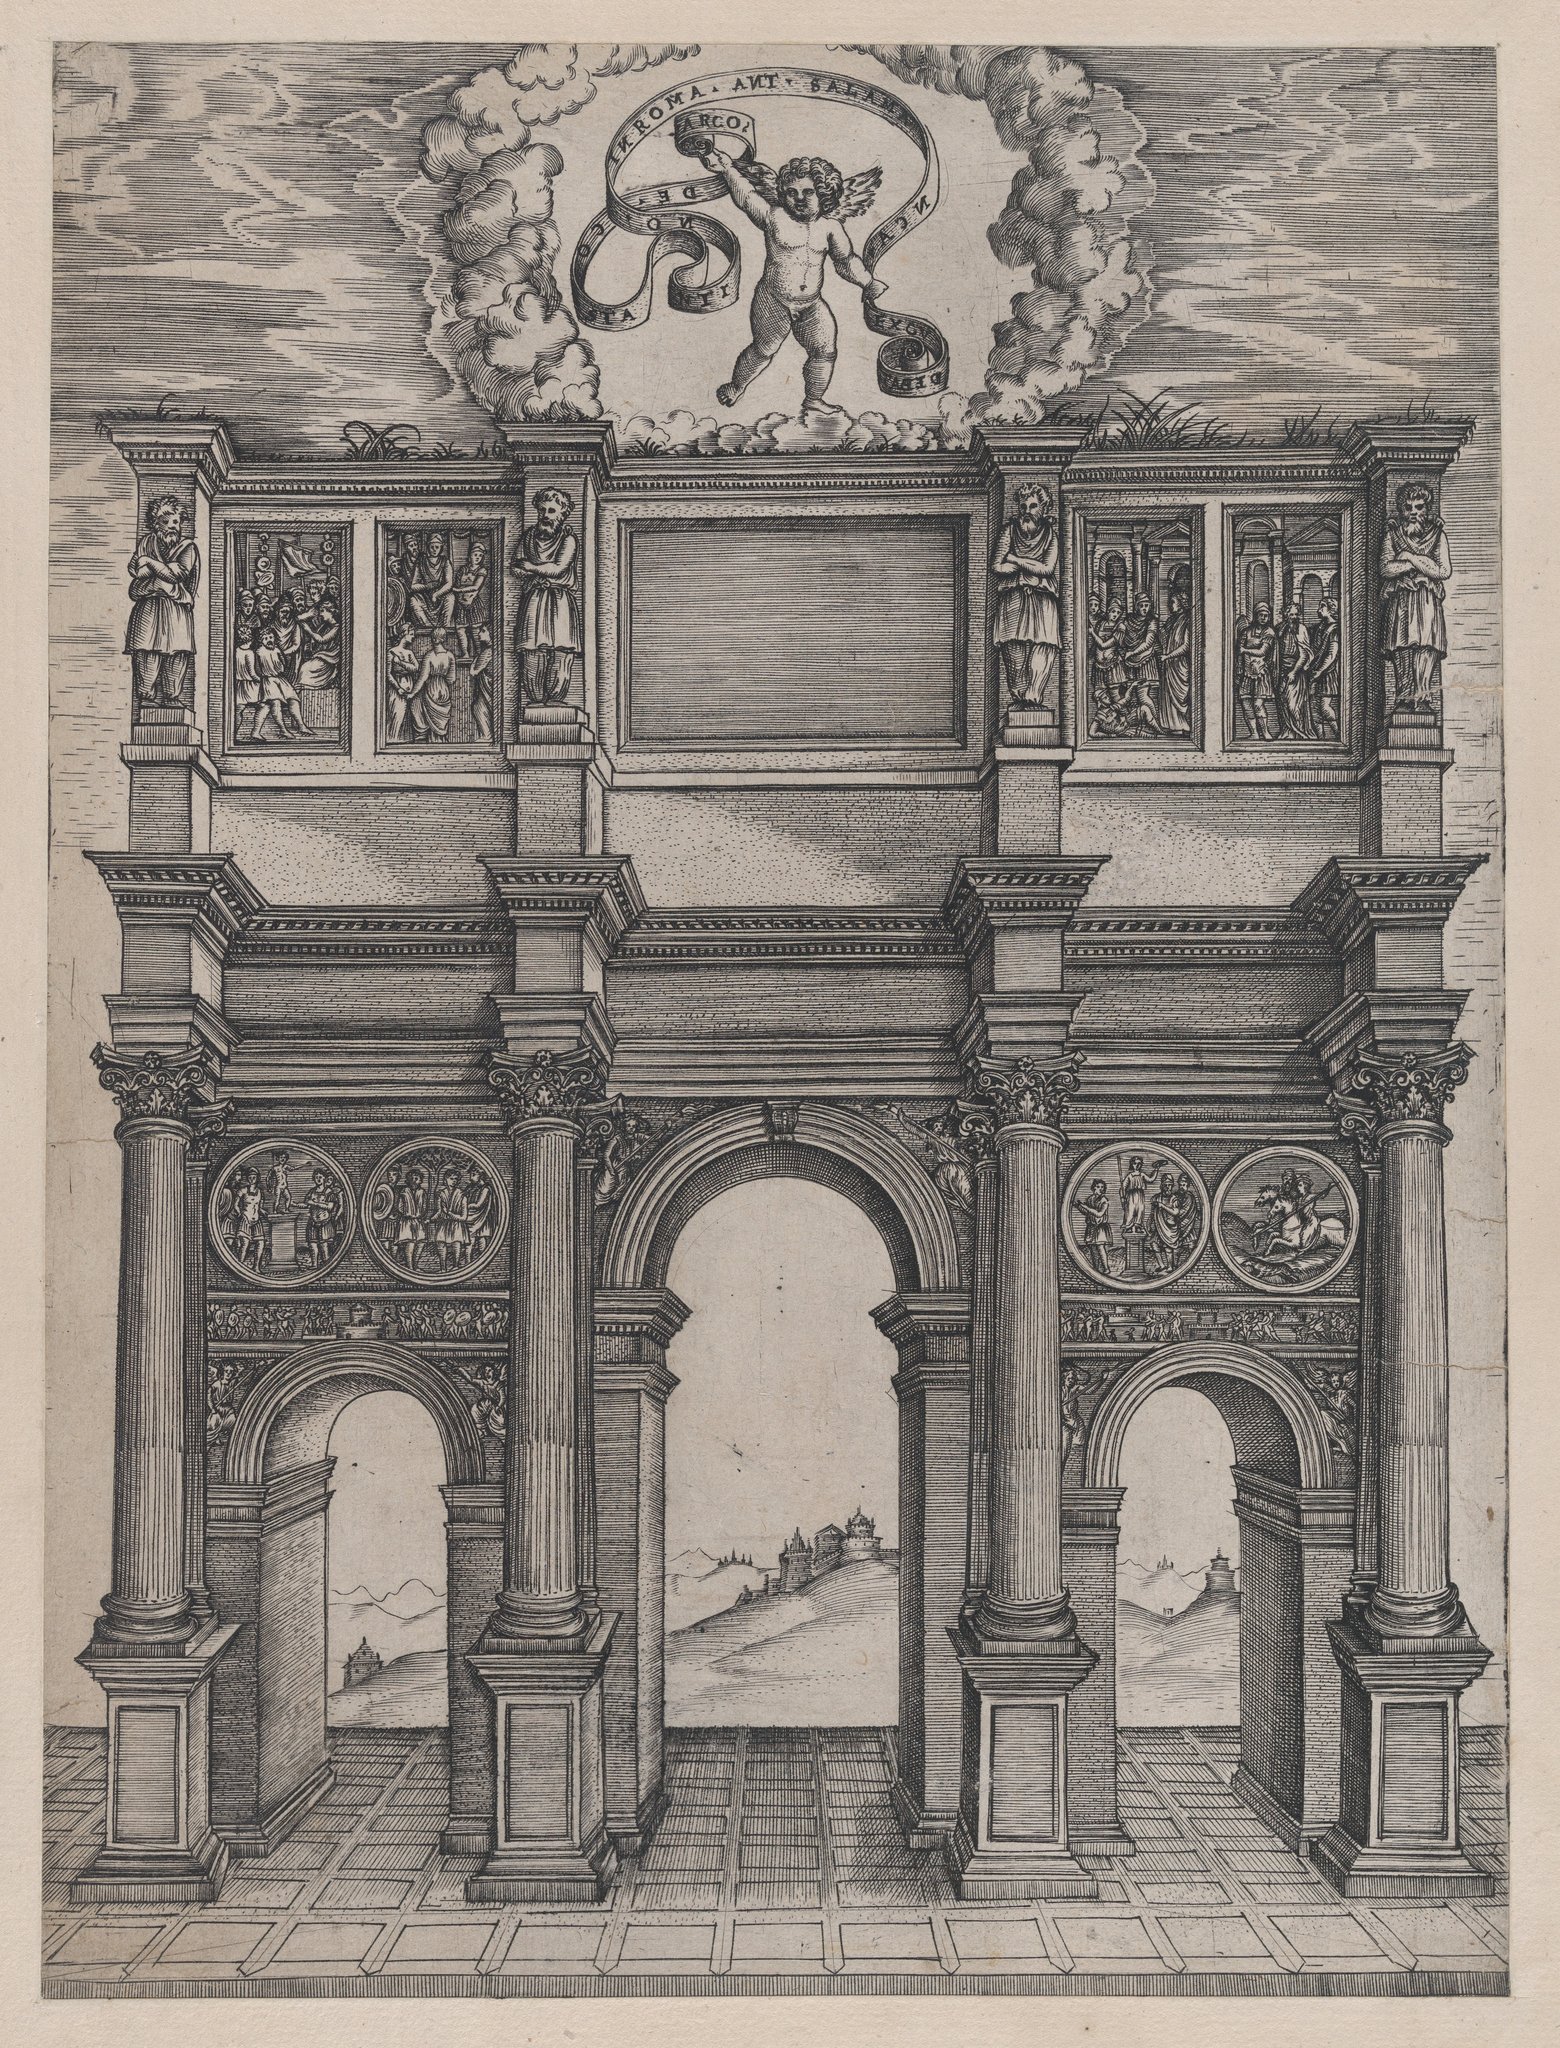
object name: print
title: The Arch of Constantine, Rome, from "Speculum Romanae Magnificentiae"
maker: agostino veneziano (agostino dei musi)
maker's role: artist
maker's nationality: italian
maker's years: 1490-1536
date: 1514-1536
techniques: engraving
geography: roman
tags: architecture,arches,capitals,columns,men,mythical creatures,rome